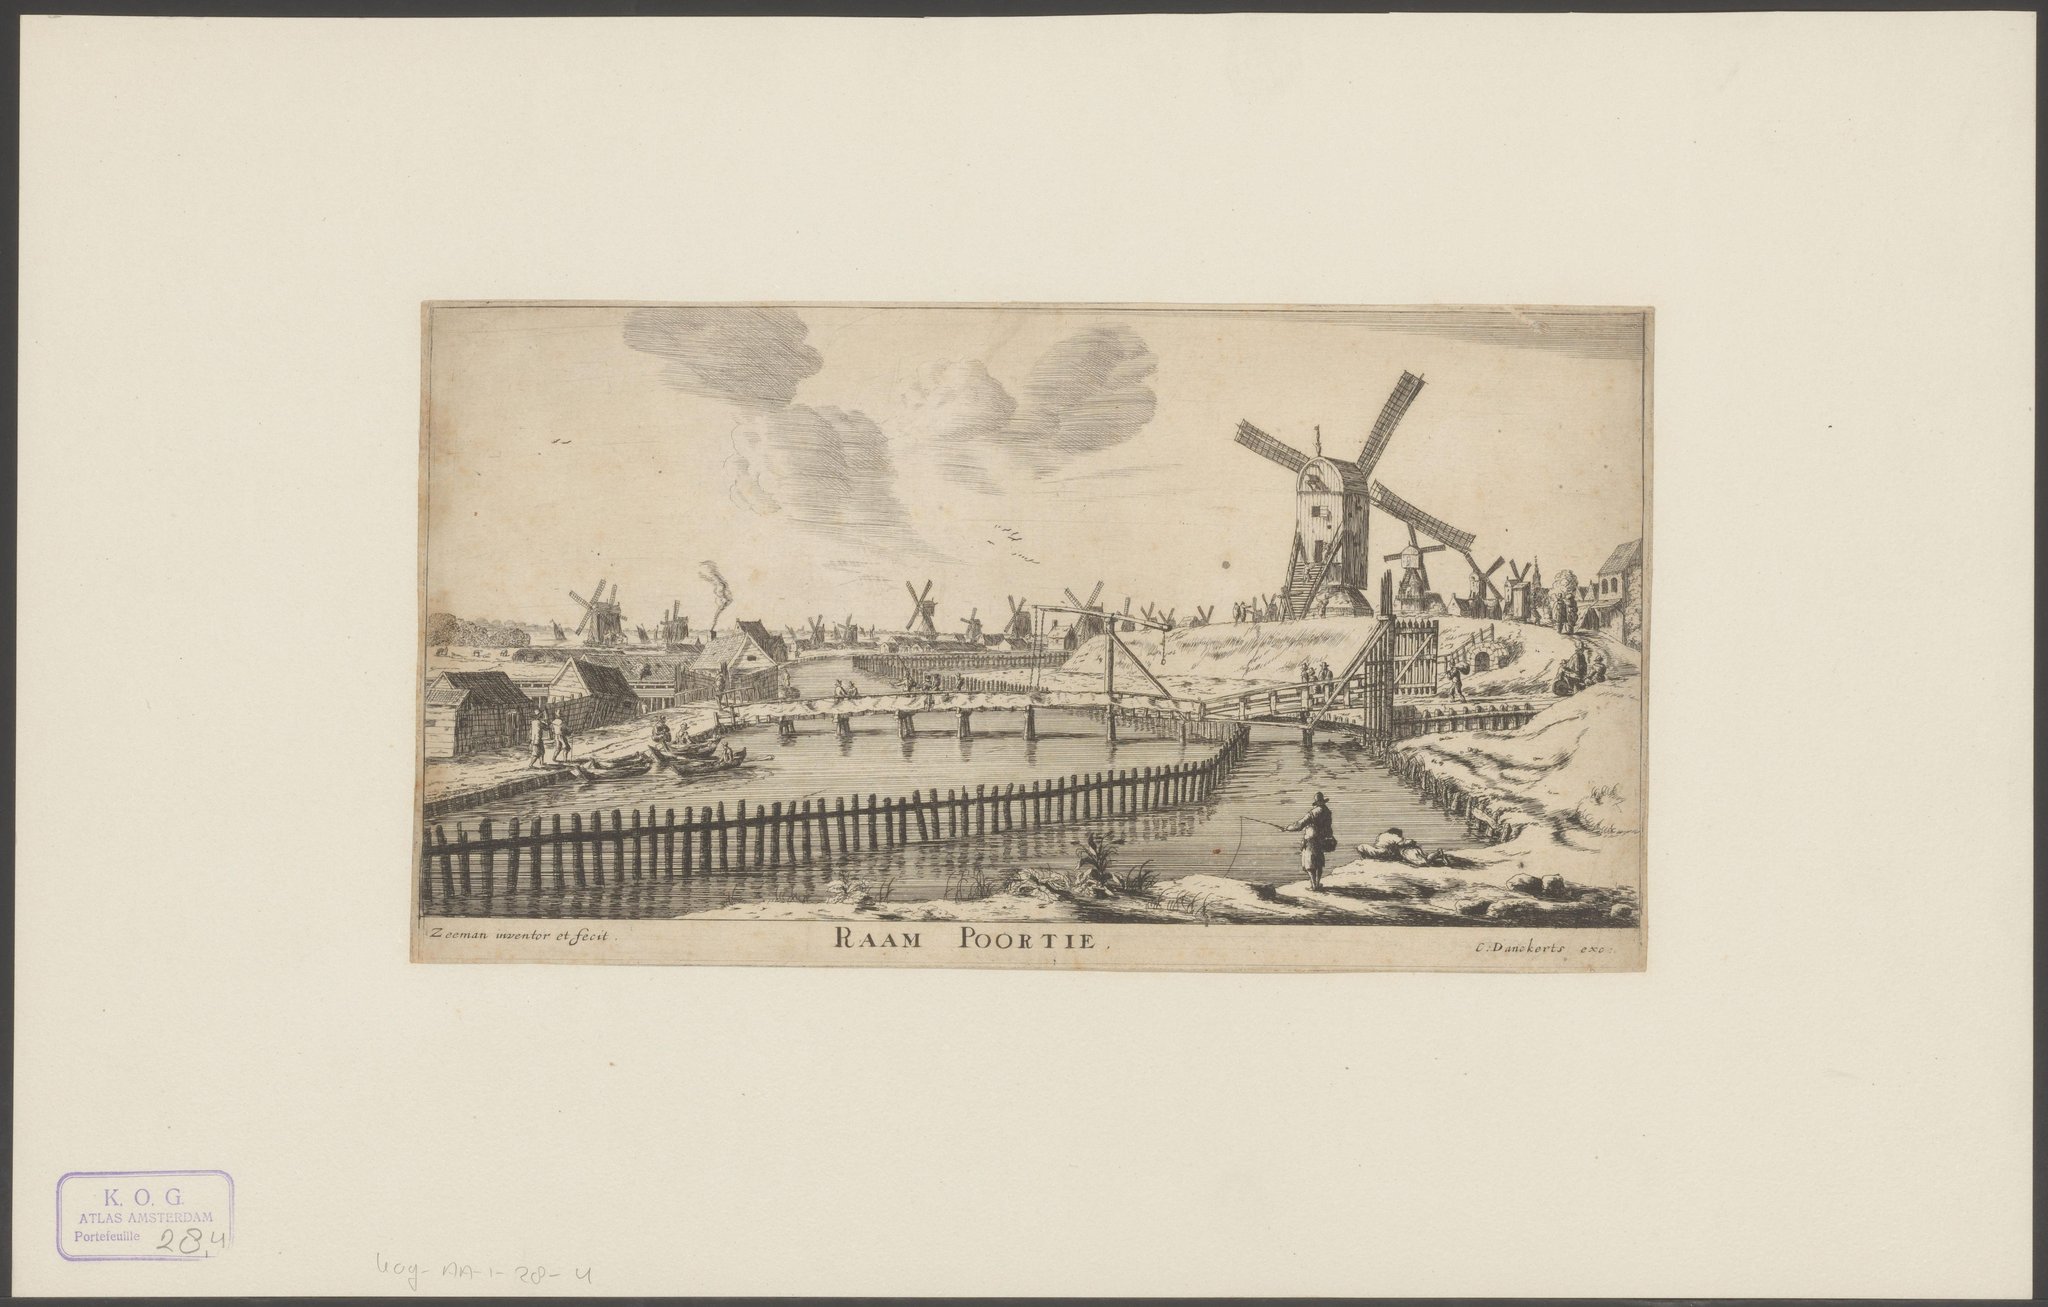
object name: print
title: Gezicht op de Raampoort te Amsterdam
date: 1654-1701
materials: paper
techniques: drypoint, engraving, etching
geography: amsterdam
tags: tower, clock tower ~ monumental adornment, windmill, city-gate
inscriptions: collector's mark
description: Onderdeel van een prentserie bestaande uit een titelprent en zeven prenten van Amsterdamse stadspoorten of alleen zeven (of zes) prenten van Amsterdamse stadspoorten. Van deze prentserie zijn drie uitgaven bekend, respectievelijk uitgegeven door Cornelis Danckerts (I), Dancker Danckerts en Justus Danckerts. Van de titelprent zijn drie staten bekend: één staat voor de letter waarop het droge naaldwerk nog goed zichtbaar is, één staat waarop Dancker Danckerts als uitgever vermeld staat; en één staat waarop Justus Danckerts als uitgever vermeld staat. De serie uitgegeven door Cornelis (I) Danckerts had mogelijk geen titelprent. Van elk van de overige prenten zijn redelijk wat exemplaren overgeleverd maar is telkens slechts één staat bekend. Op vier van deze prenten staat Cornelis Danckerts (I) vermeld als uitgever. Op twee prenten staat geen uitgever vermeld en op één prent staat Dancker Danckerts vermeld als uitgever. Mogelijk hebben zowel Dancker als Justus voor hun uitgave hun naam op de titelprent vermeld zonder de overige prenten bij te werken. Dat zou betekenen dat de prenten waarop Cornelis (I) staat vermeld als uitgever, ook later door zijn zoons Dancker en Justus kunnen zijn uitgegeven. En dat de prent waarop Danker vermeld staat als uitgever ook door Justus kan zijn uitgeven. Dat op de prent van de Derde Regulierspoort (RP-P-AO-27-15-2 en RP-P-1882-A-6003) wel - in een net andere stijl - de naam van Dancker Danckerts staat, zou verklaard kunnen worden doordat deze prent iets later, na het overlijden van Cornelis (I) in 1656, aan de serie is toegevoegd. De serie bevat namelijk ook een prent van de Tweede Regulierspoort (RP-P-AO-27-4-2 en RP-P-OB-20.579). Deze houten poort werd in 1654 afgebroken en vervangen door de stenen Derde Regulierspoort die in 1655 voltooid zou zijn.